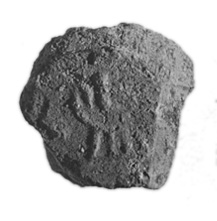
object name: sealing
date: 2030-1640 BCE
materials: clay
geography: egypt